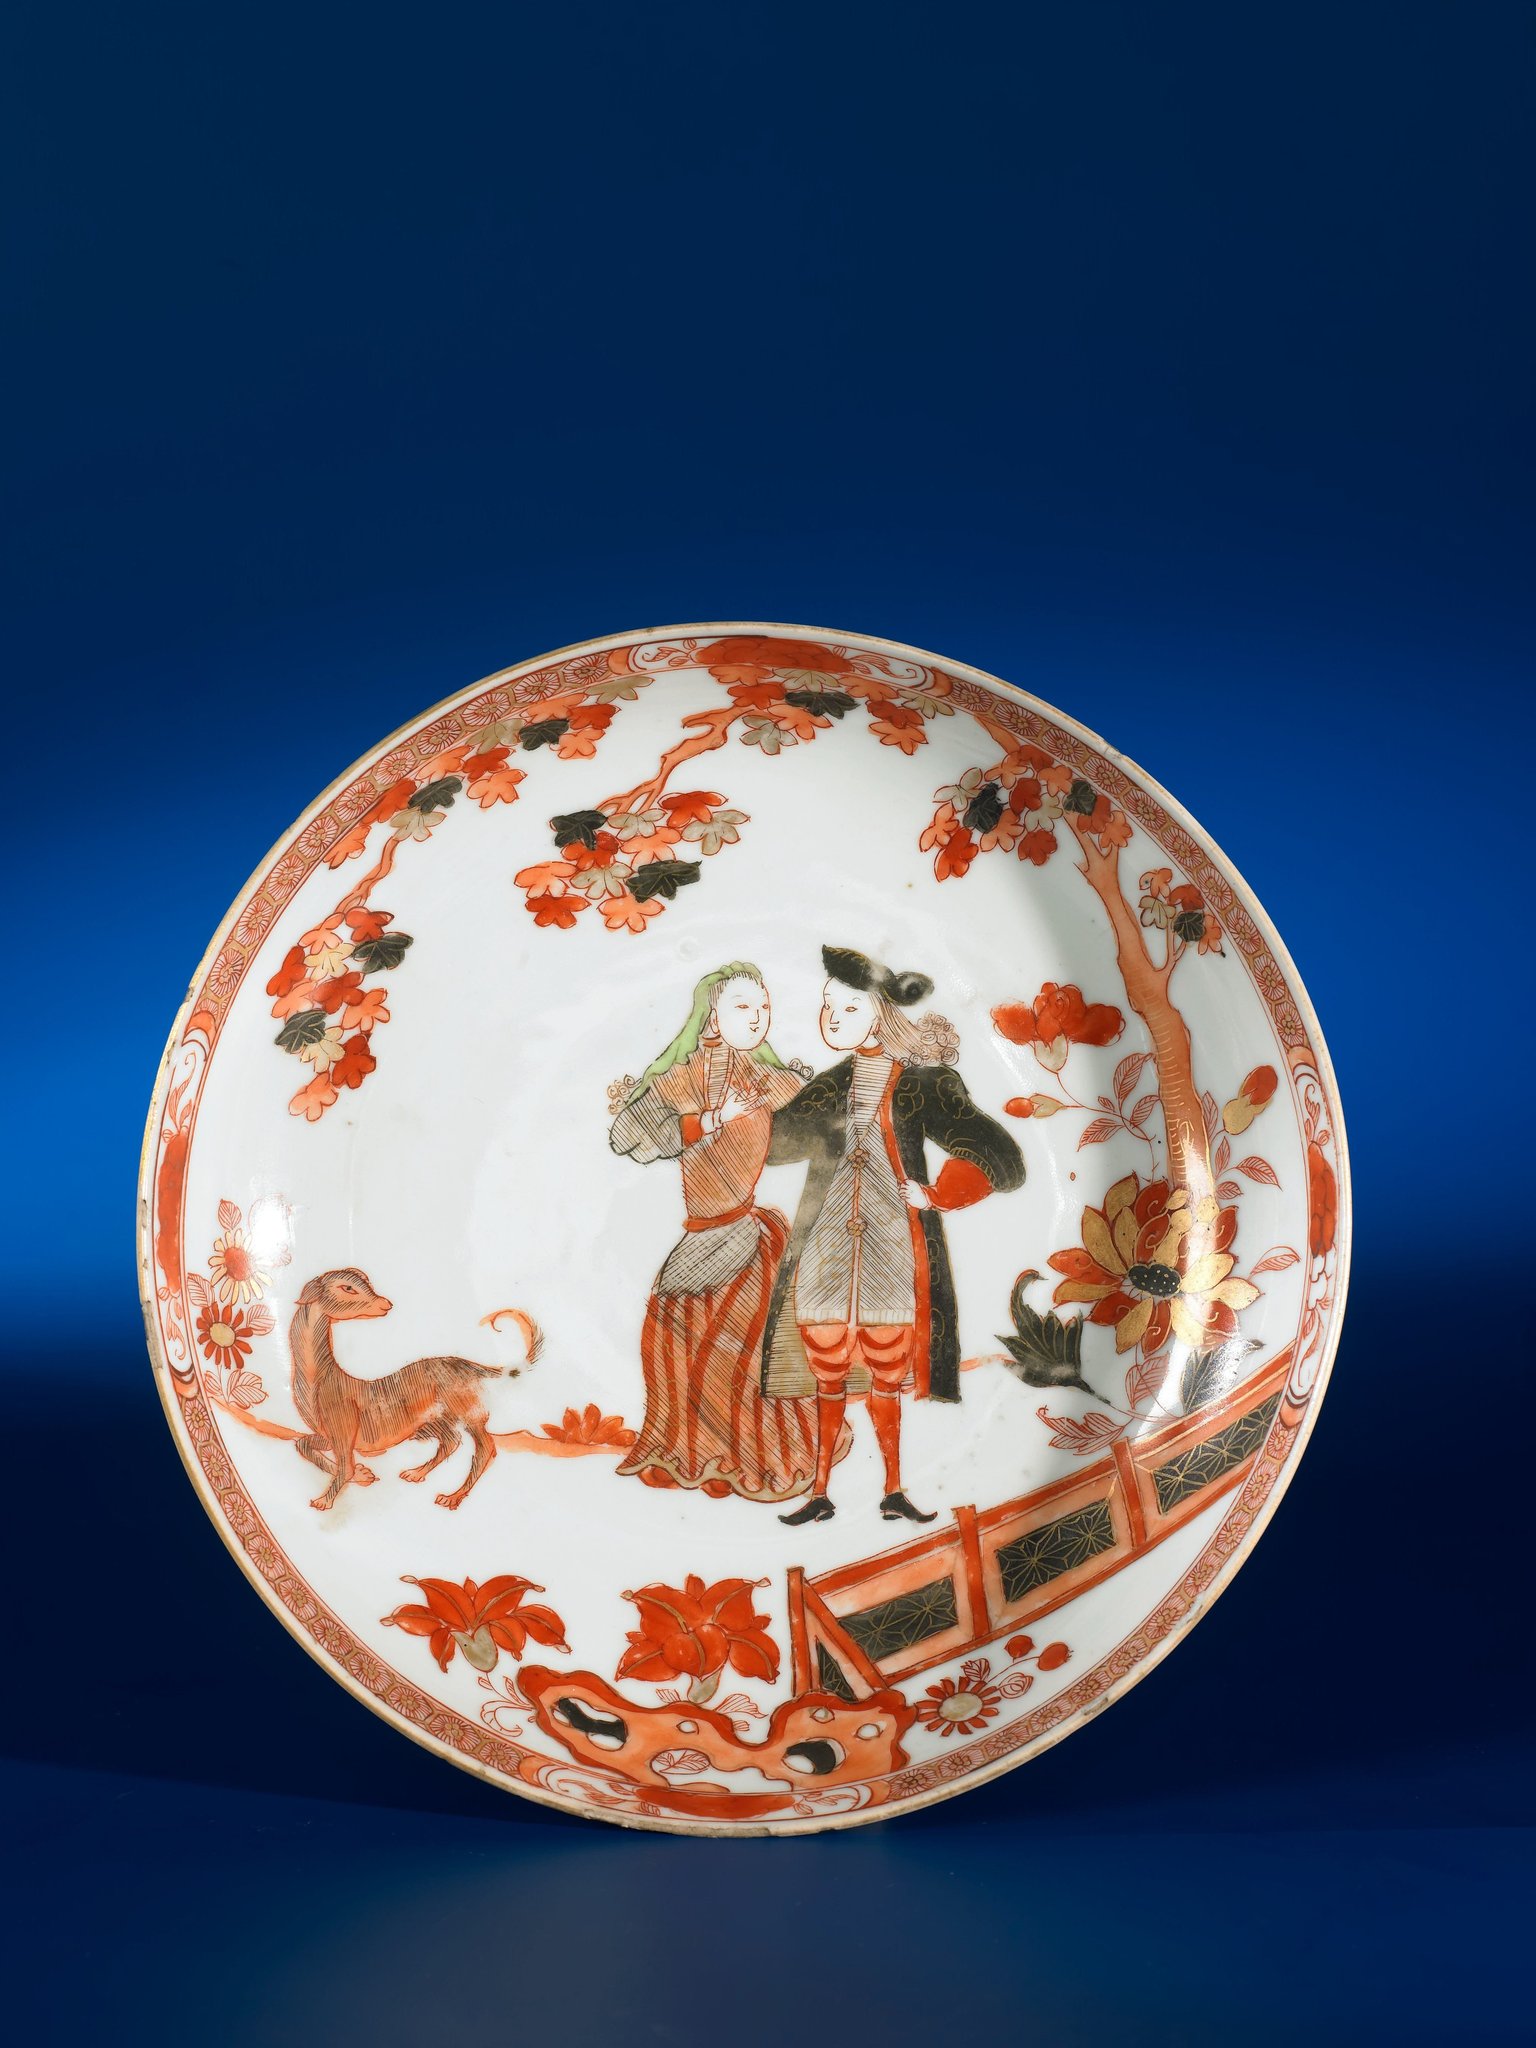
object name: dish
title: Saucer-dish with a Dutch couple and a dog in a fenced garden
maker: Anonymous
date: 1700-1724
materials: glaze, gold, paint, porcelain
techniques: firing, gilding, turning, vitrification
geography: china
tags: china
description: Schaal op een voetring, gedecoreerd in ijzerrood, goud en emailkleuren. Centraal een voorstelling van een dame, een heer en een hond in een Chinees landschap of tuin. De dame en heer op deze voorstelling worden de literatuur in verband gebracht met gouverneur-generaal Diederik Durven (1676-1740) en zijn vrouw. De gouverneur was in de eerste helft van de 18de eeuw in dienst van de VOC en bekleedde een post in Indië. Tevens wordt wel geopperd dat de dame en de heer op het bord Lodewijk XIV en Madame de Maintenon zouden kunnen zijn: voor beide veronderstellingen is echter geen bewijs, een prent of tekening die als voorbeeld zou hebben gediend is nog niet gevonden. Het is dan ook aannemelijker dat het een voorstelling betreft van een Europees, wellicht Hollands echtpaar.